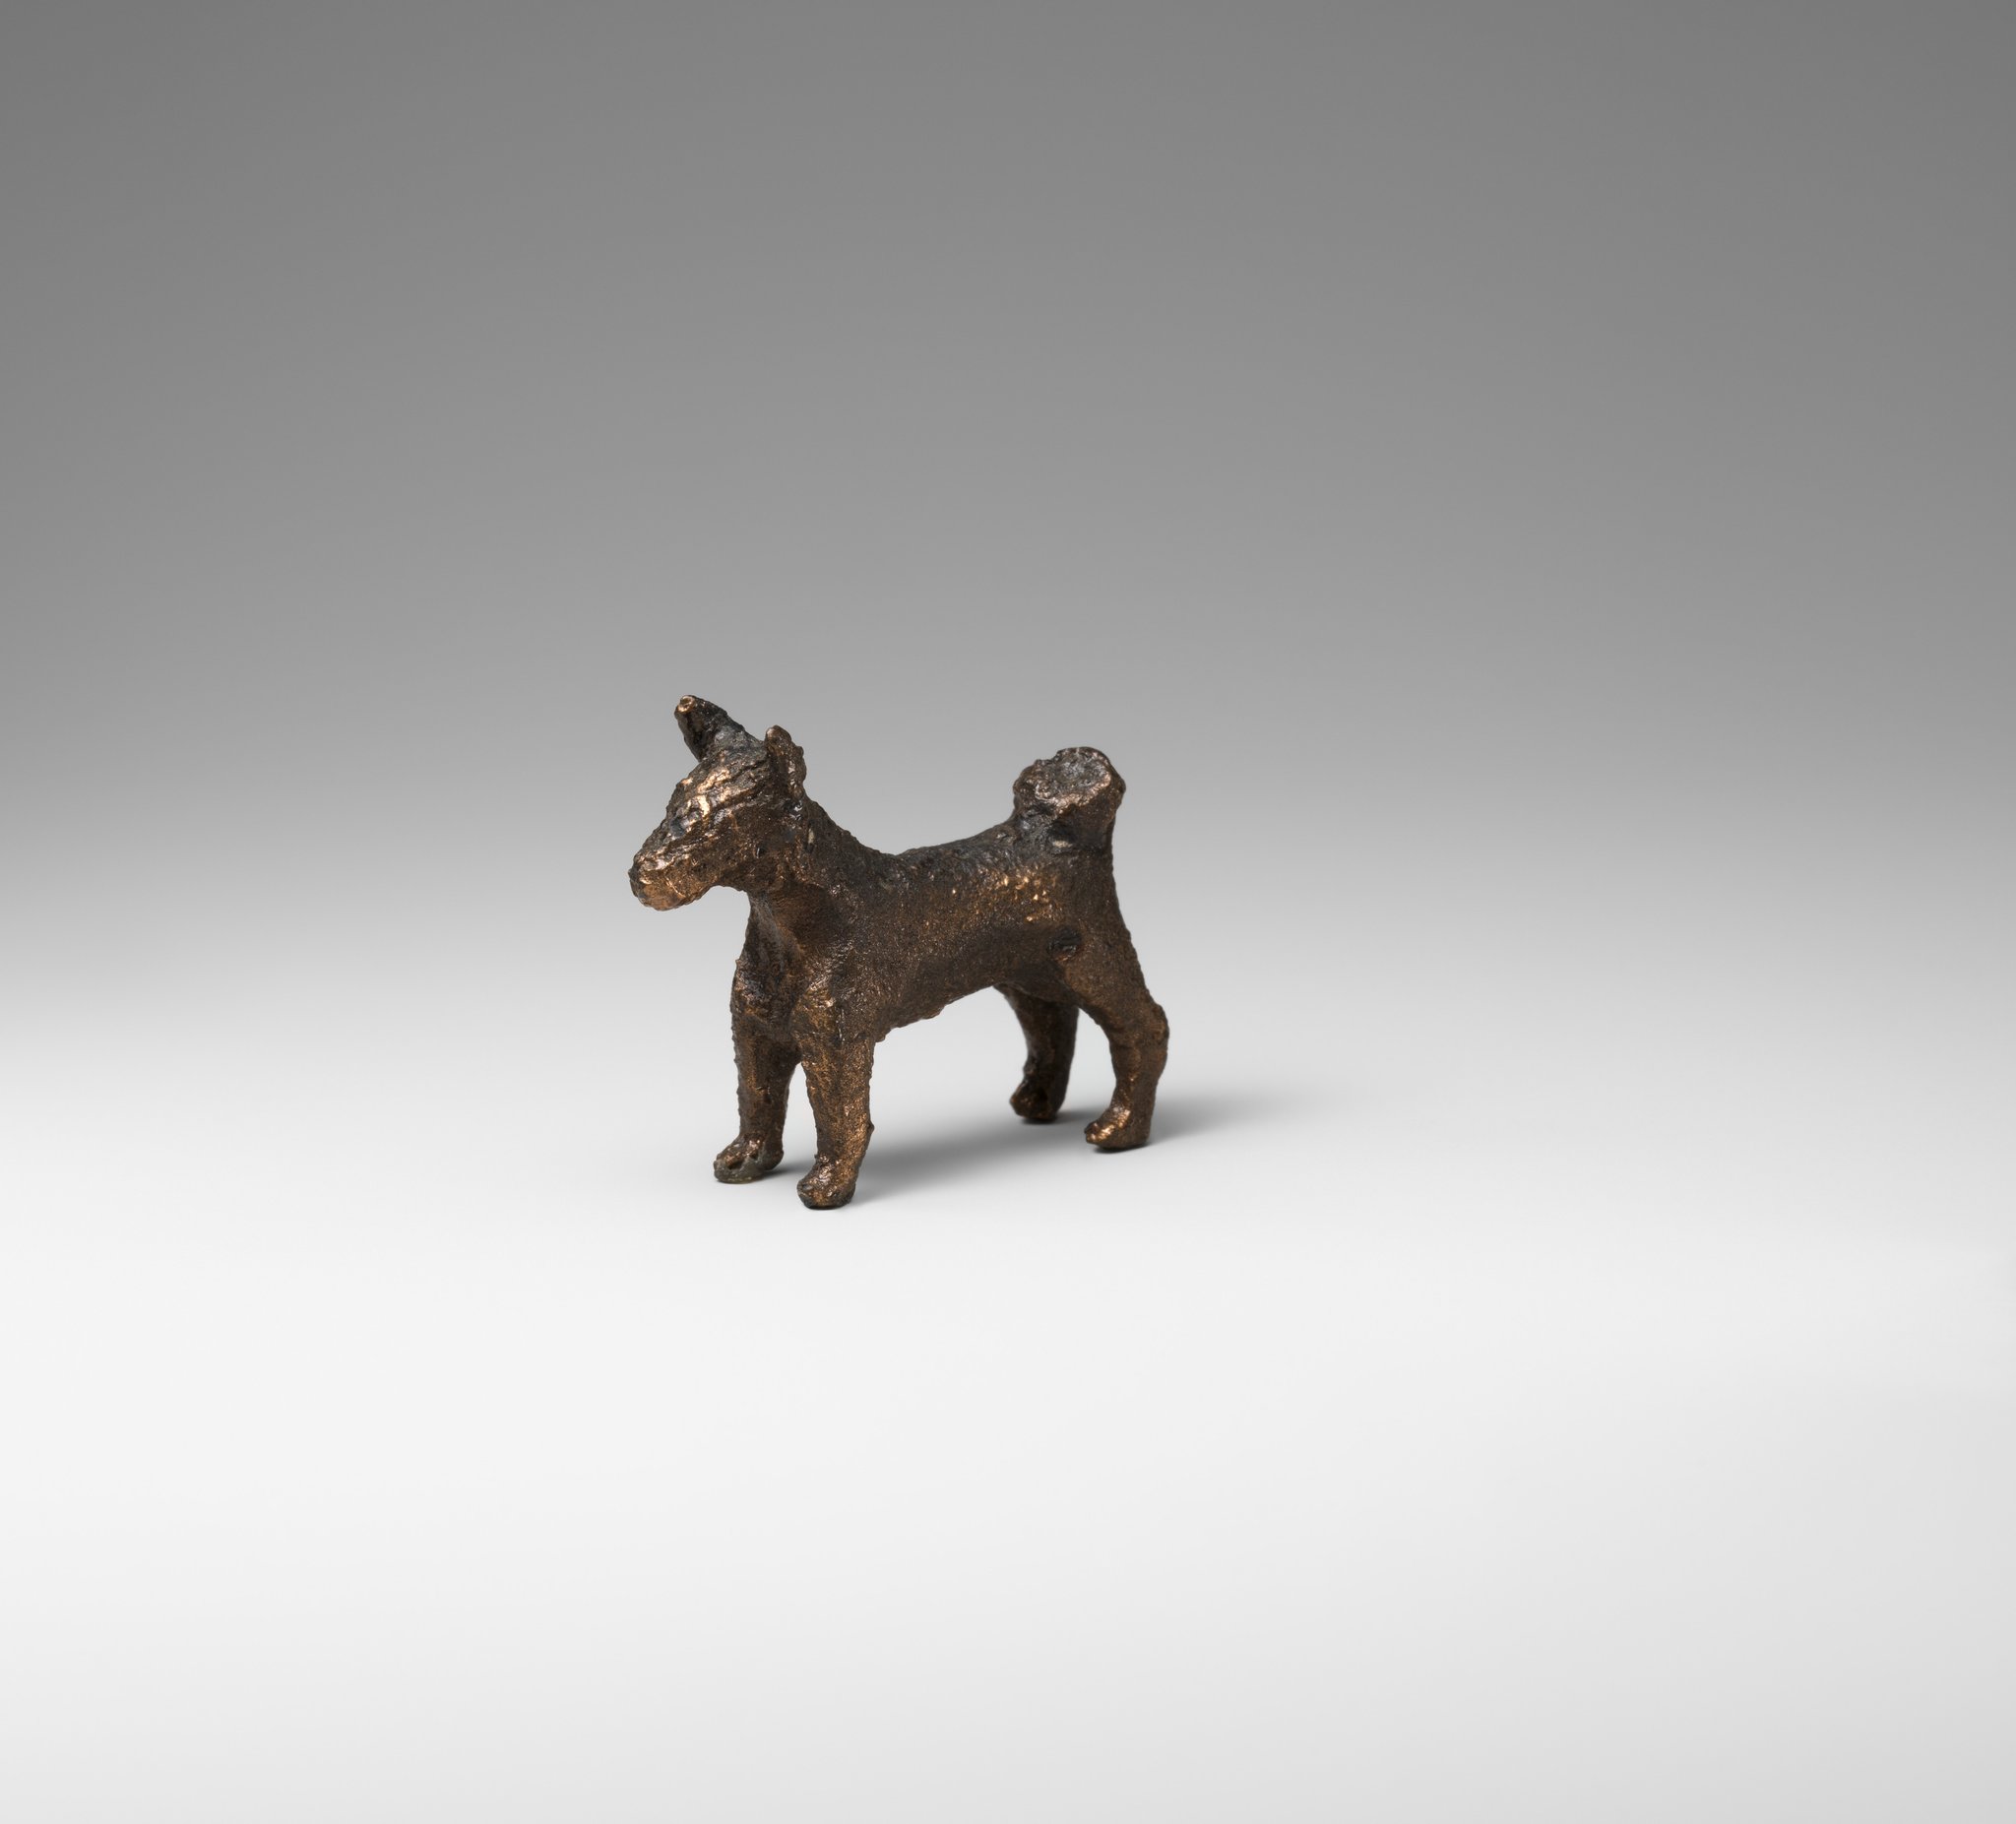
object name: sculpture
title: Dog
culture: assyrian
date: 900-701 BCE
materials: bronze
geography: mesopotamia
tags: dogs